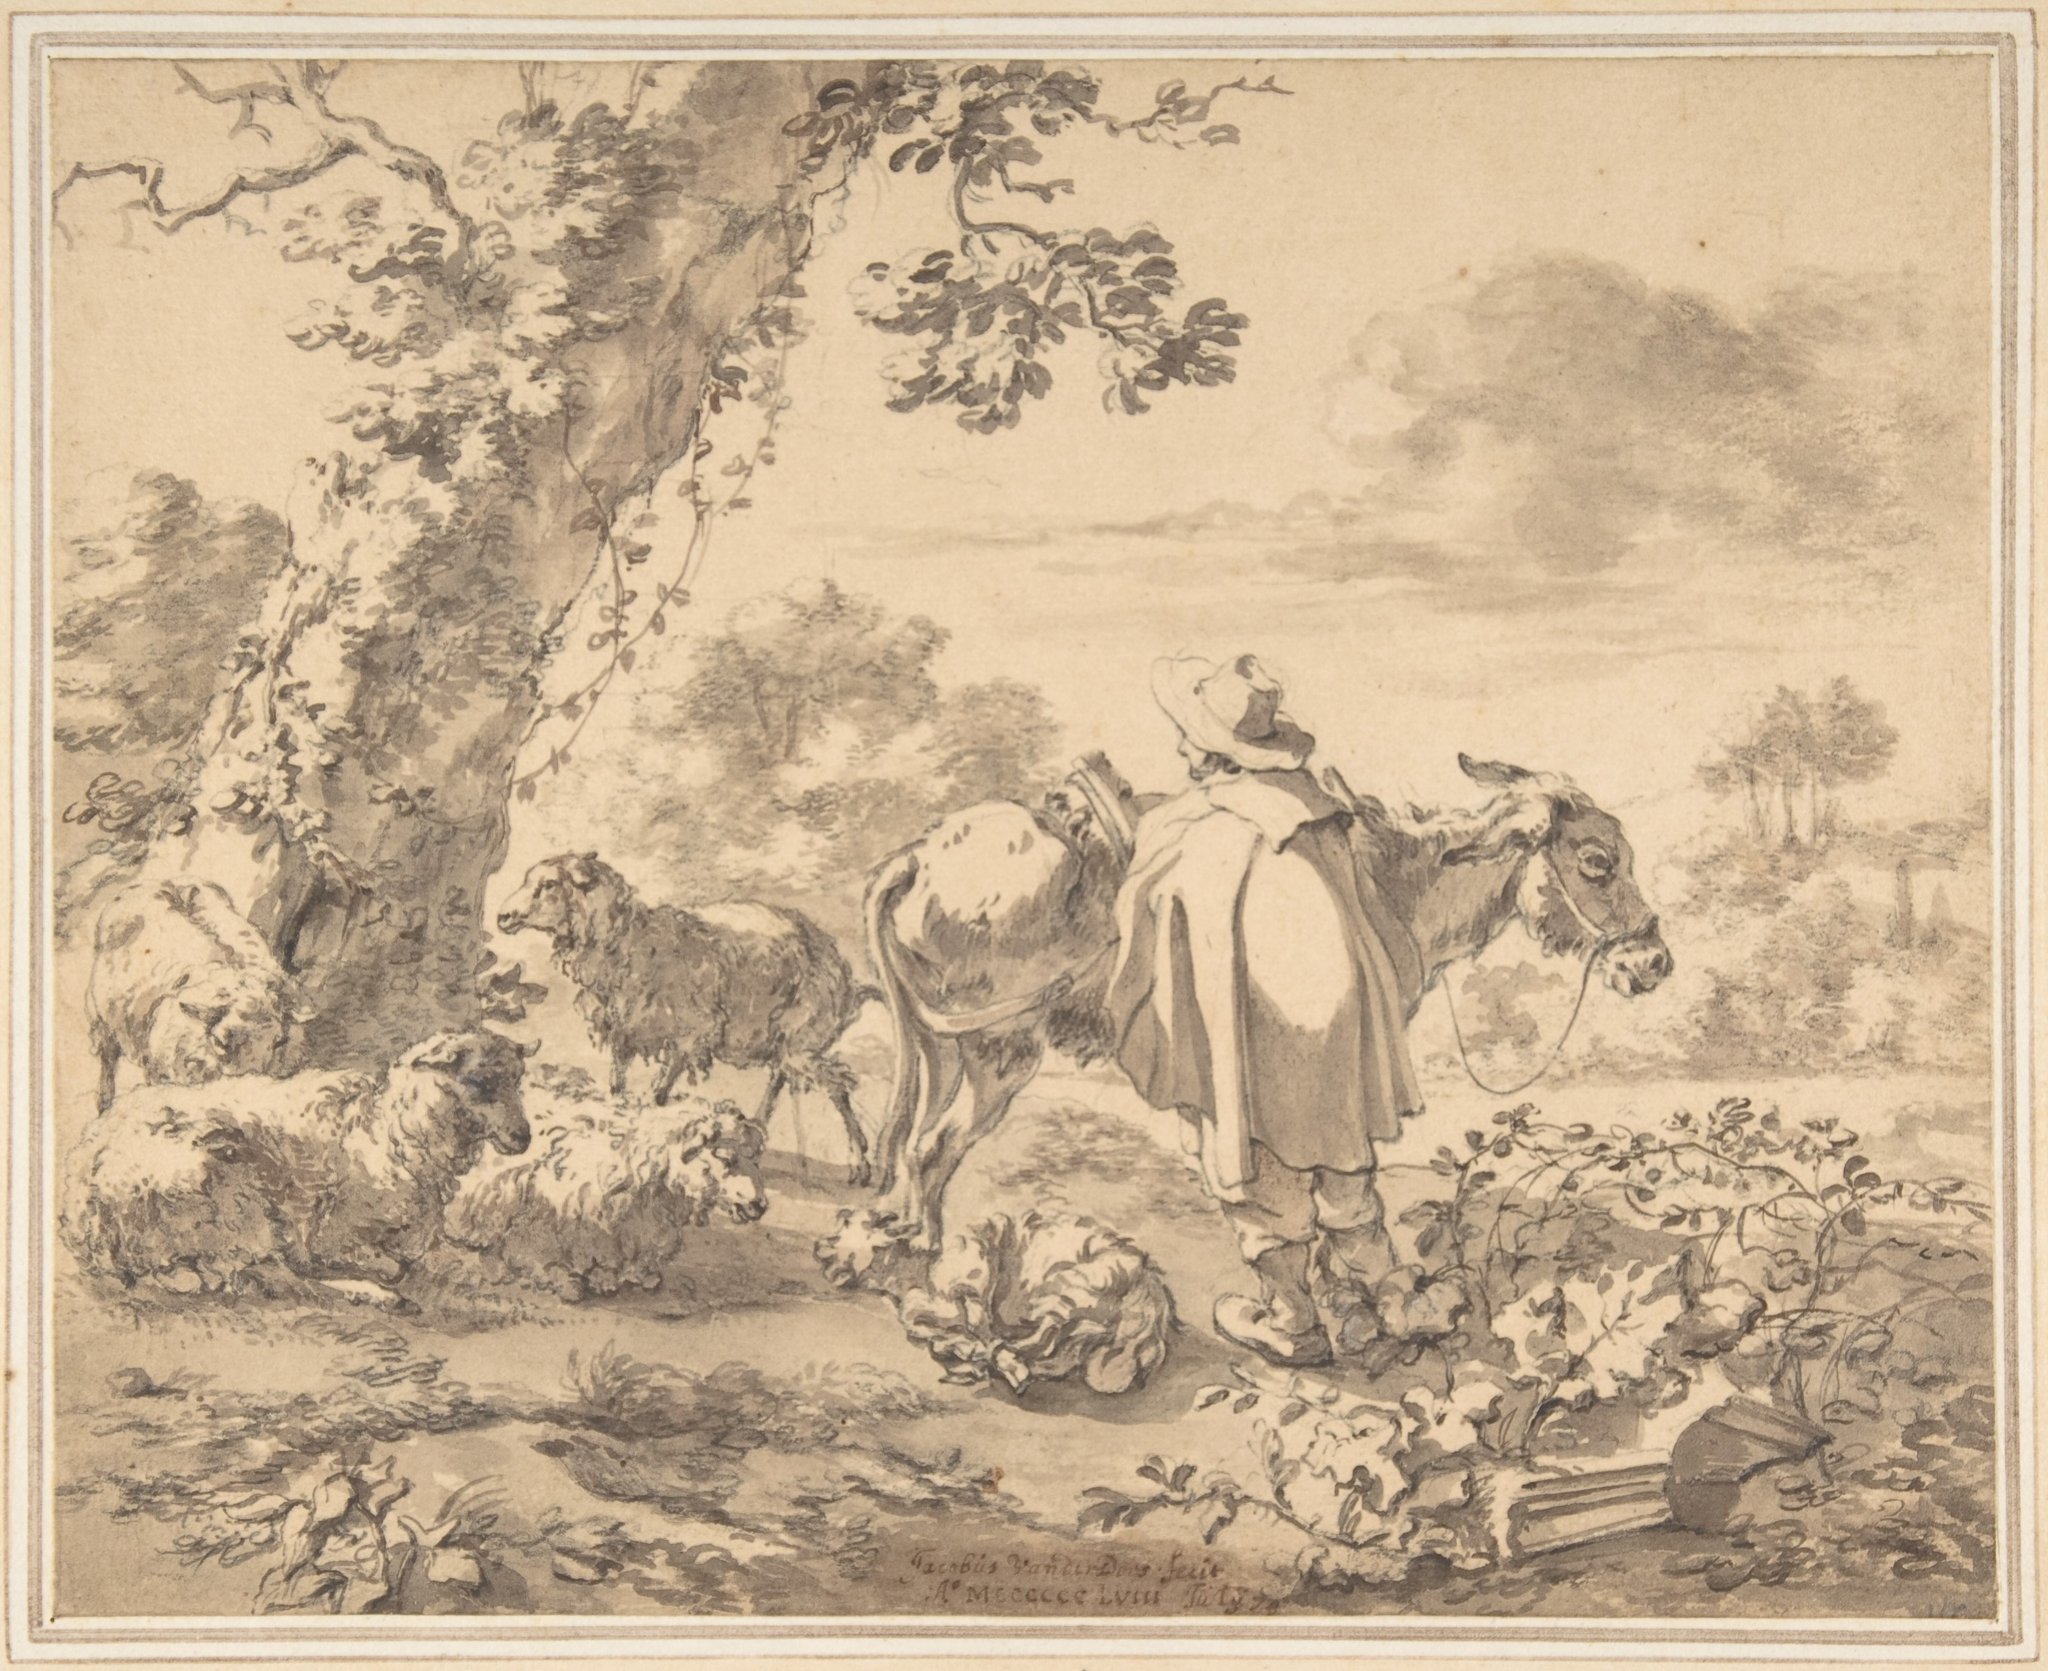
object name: drawing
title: A Herdsman with a Donkey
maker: jacob van der does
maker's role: artist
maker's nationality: dutch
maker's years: 1623-1673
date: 1658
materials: chalk, ink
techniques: brush, pen, wash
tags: men,donkeys,trees